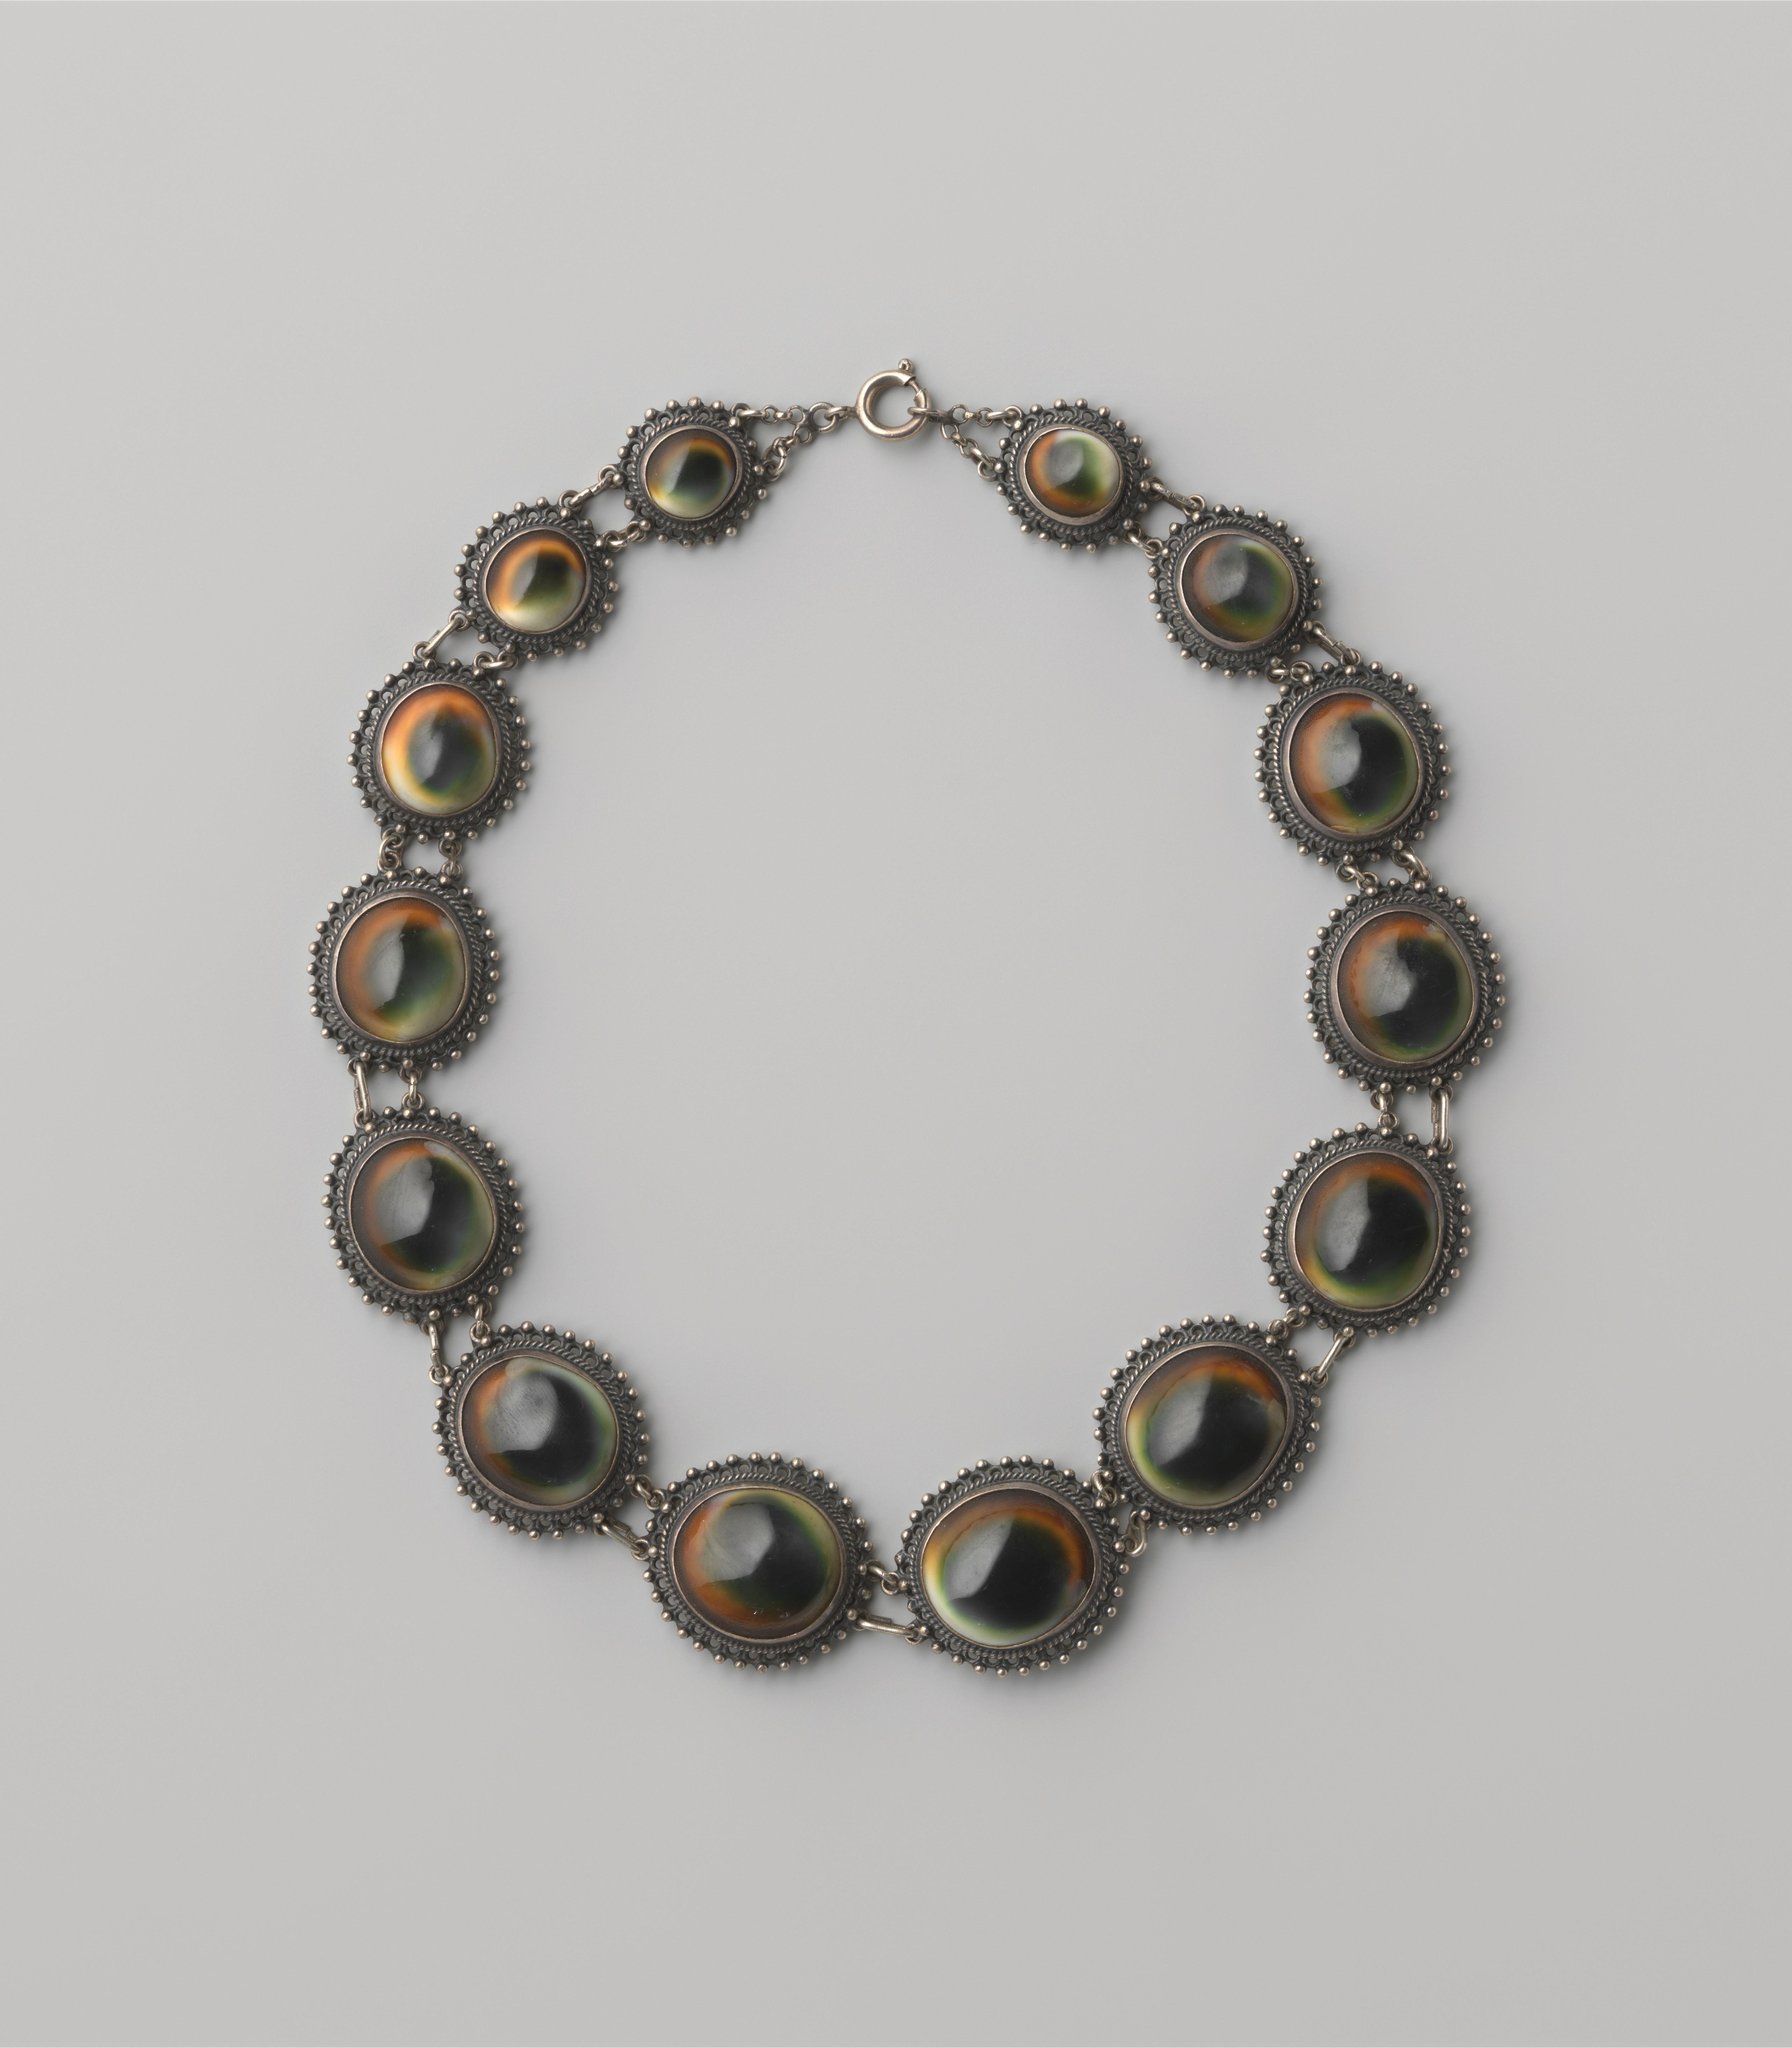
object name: necklace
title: Collier van zilver met gepolijste schelpen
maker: Anonymous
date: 1953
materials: shell, silver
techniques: polish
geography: netherlands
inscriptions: maker's mark, alloy mark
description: Collier van zilver met gepolijste schelpen gezet in ovale kasten van zilver met een parelrand.